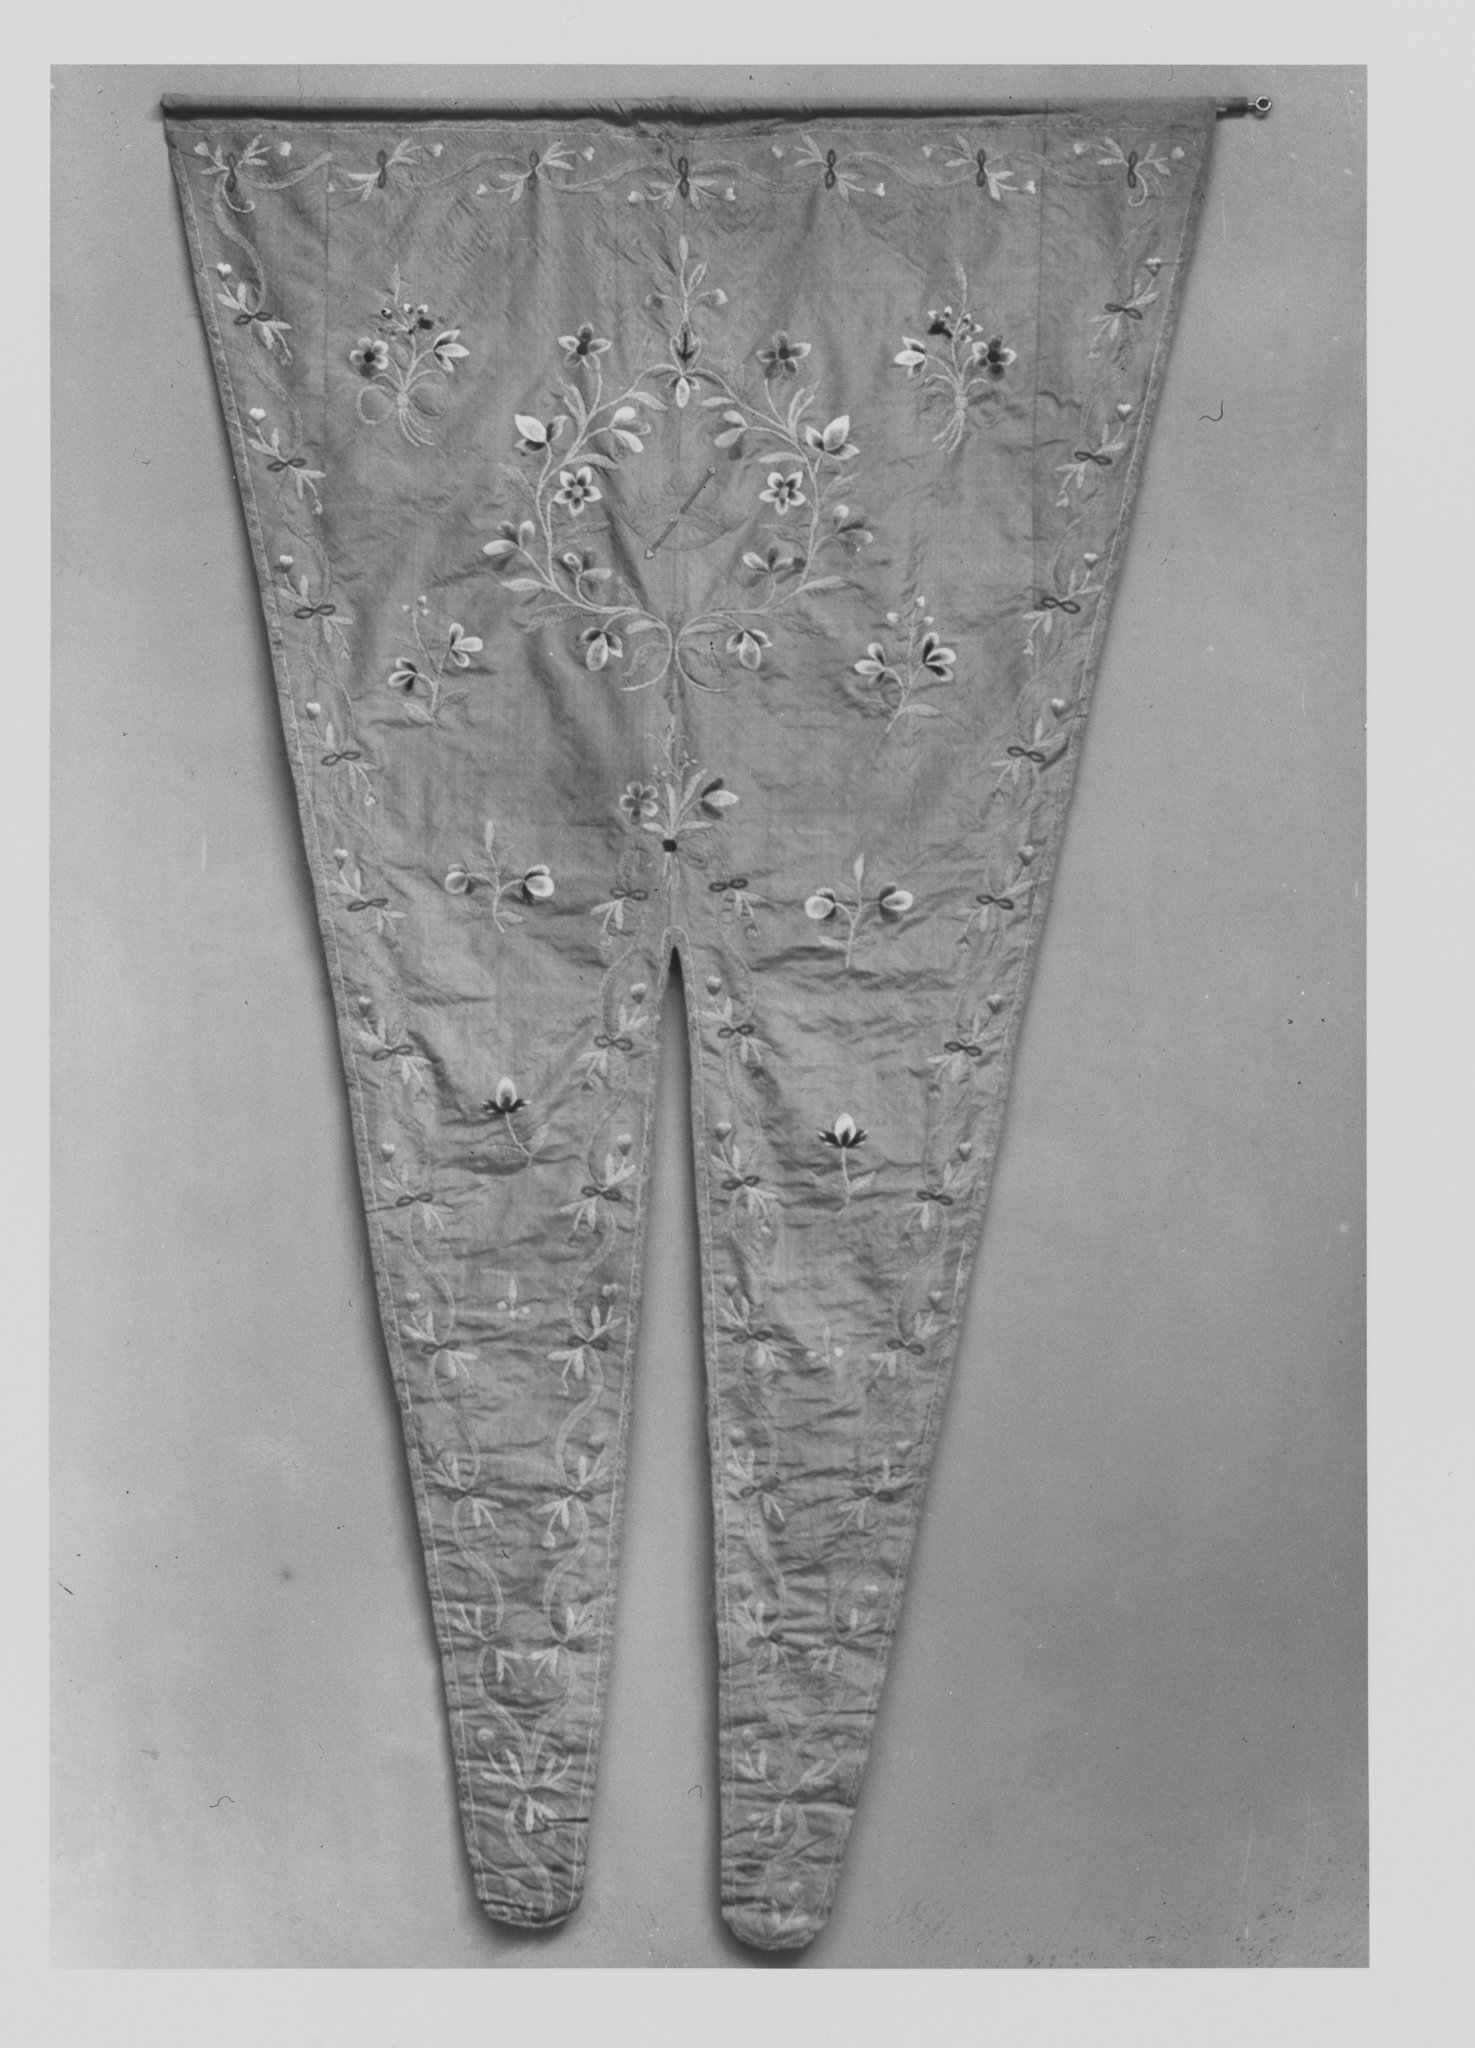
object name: church banner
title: Banner from a Church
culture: french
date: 1701-1800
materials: silk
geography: france